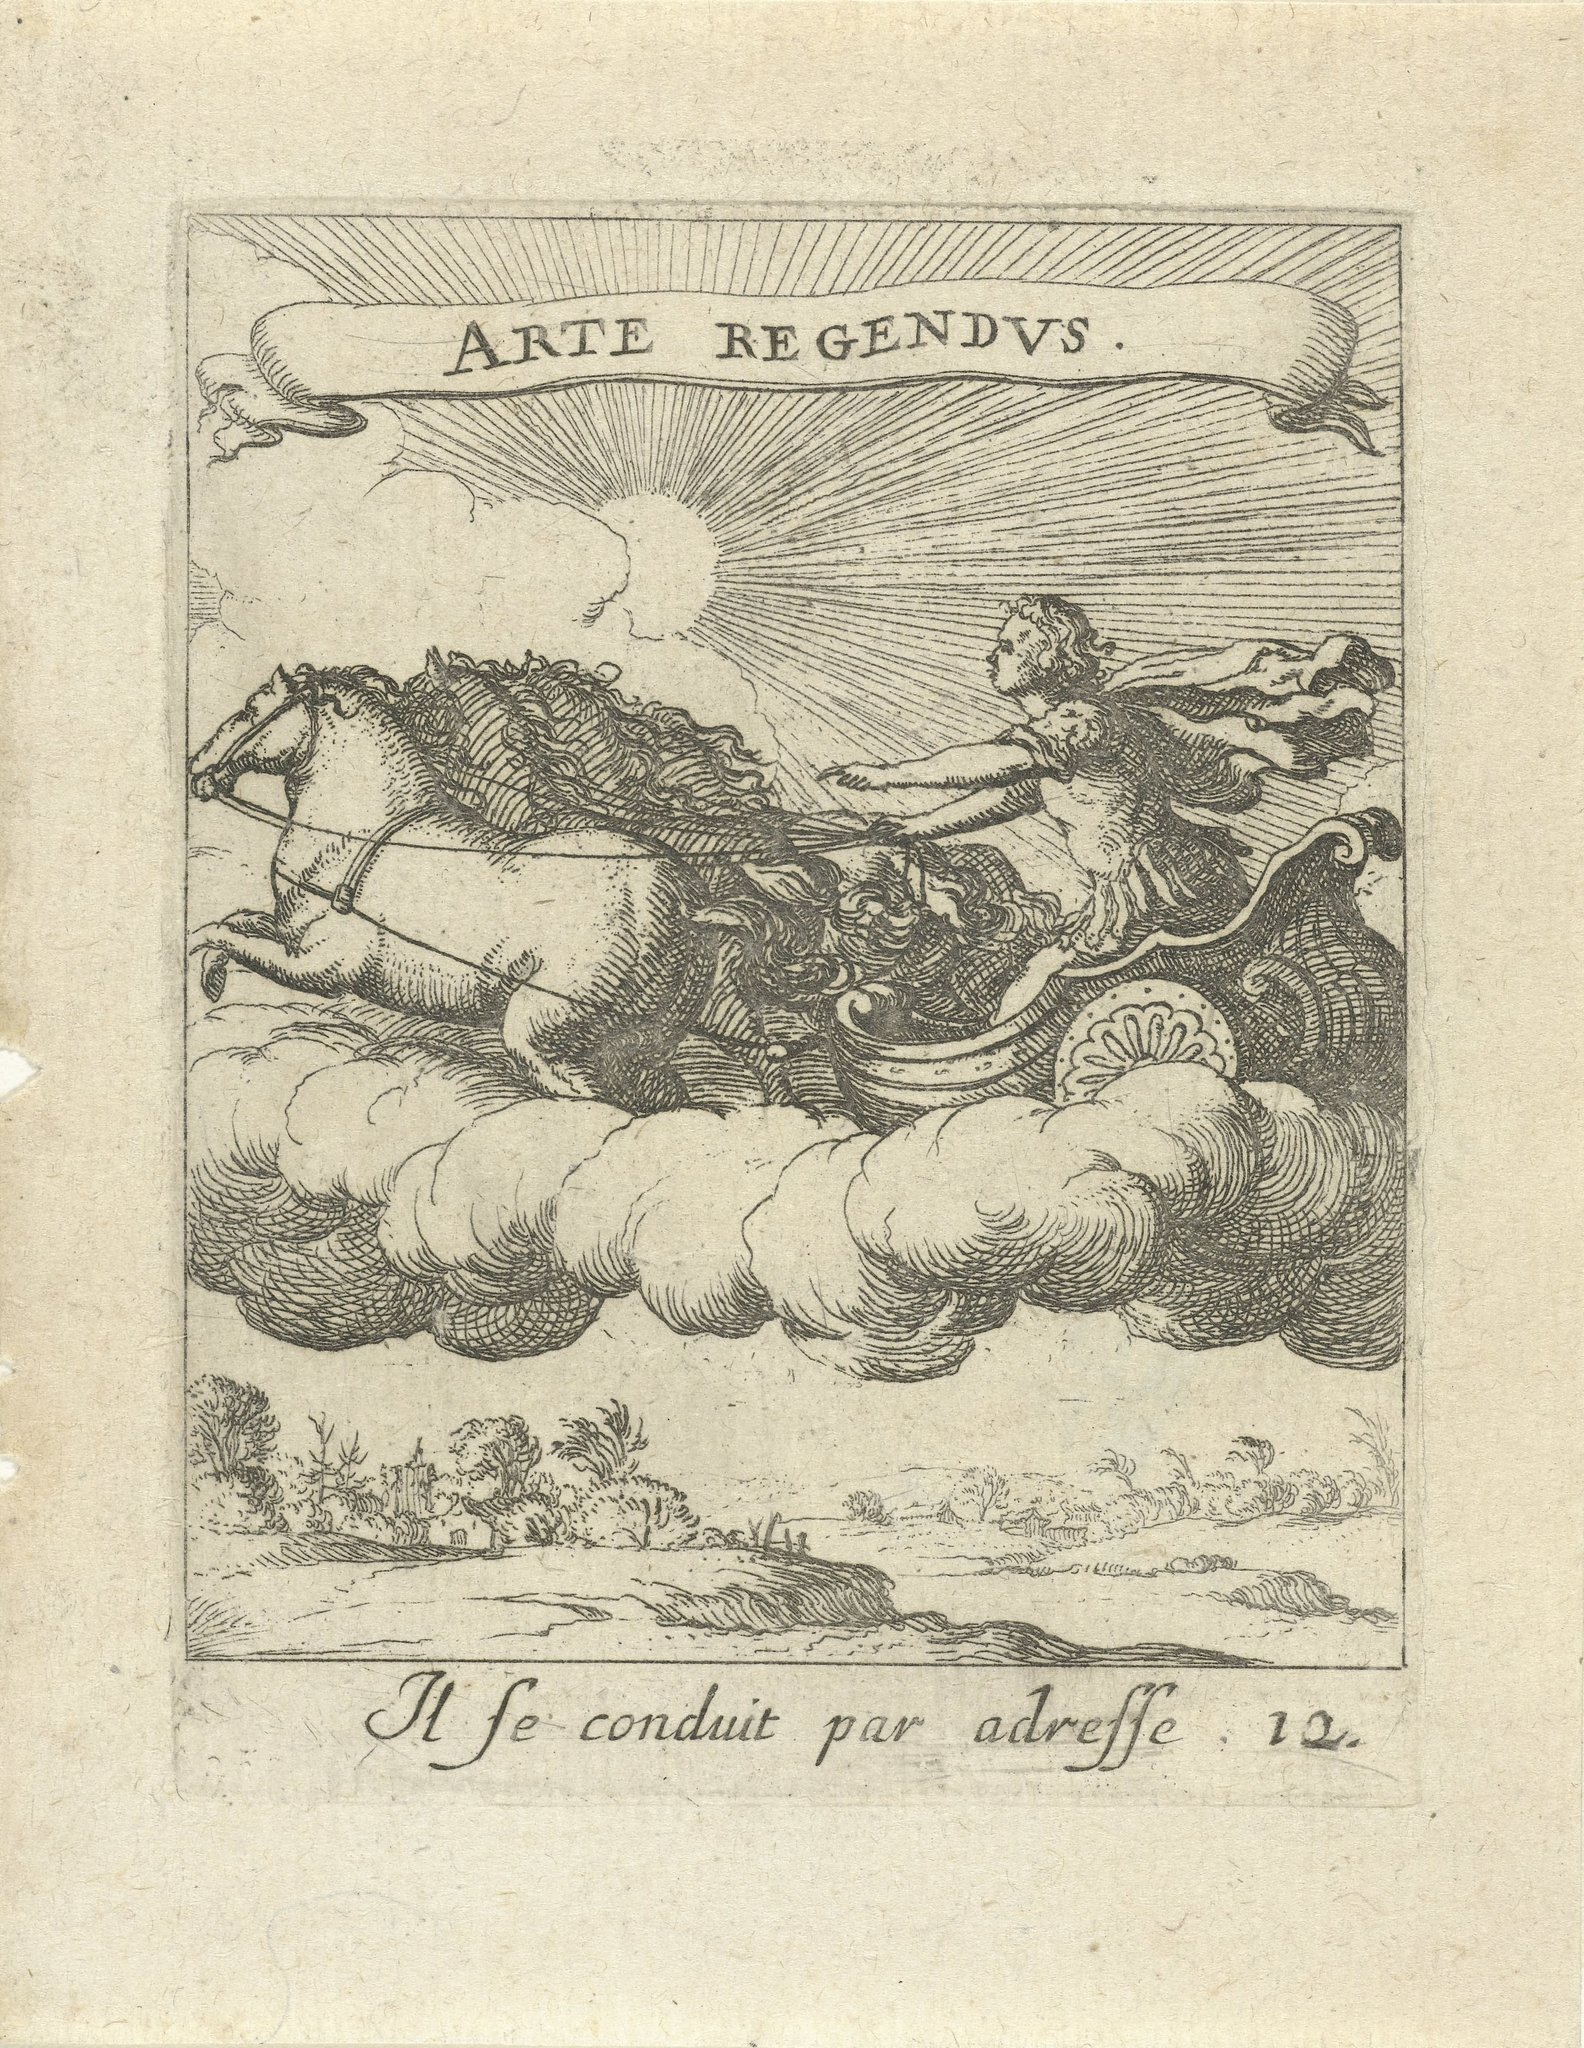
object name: print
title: Devises et emblesmes d'amovr moralisez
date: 1672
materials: paper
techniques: etching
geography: paris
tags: qualities of love: first series (+ emblematical representation of concept)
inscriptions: collector's mark: Lugt 2166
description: Apollo rijdt in zijn wagen, getrokken door paarden, langs de hemel. Onder de wolken een landschap. Op een banderol een devies in Latijn en een onderschrift in Frans, beide over de liefde.